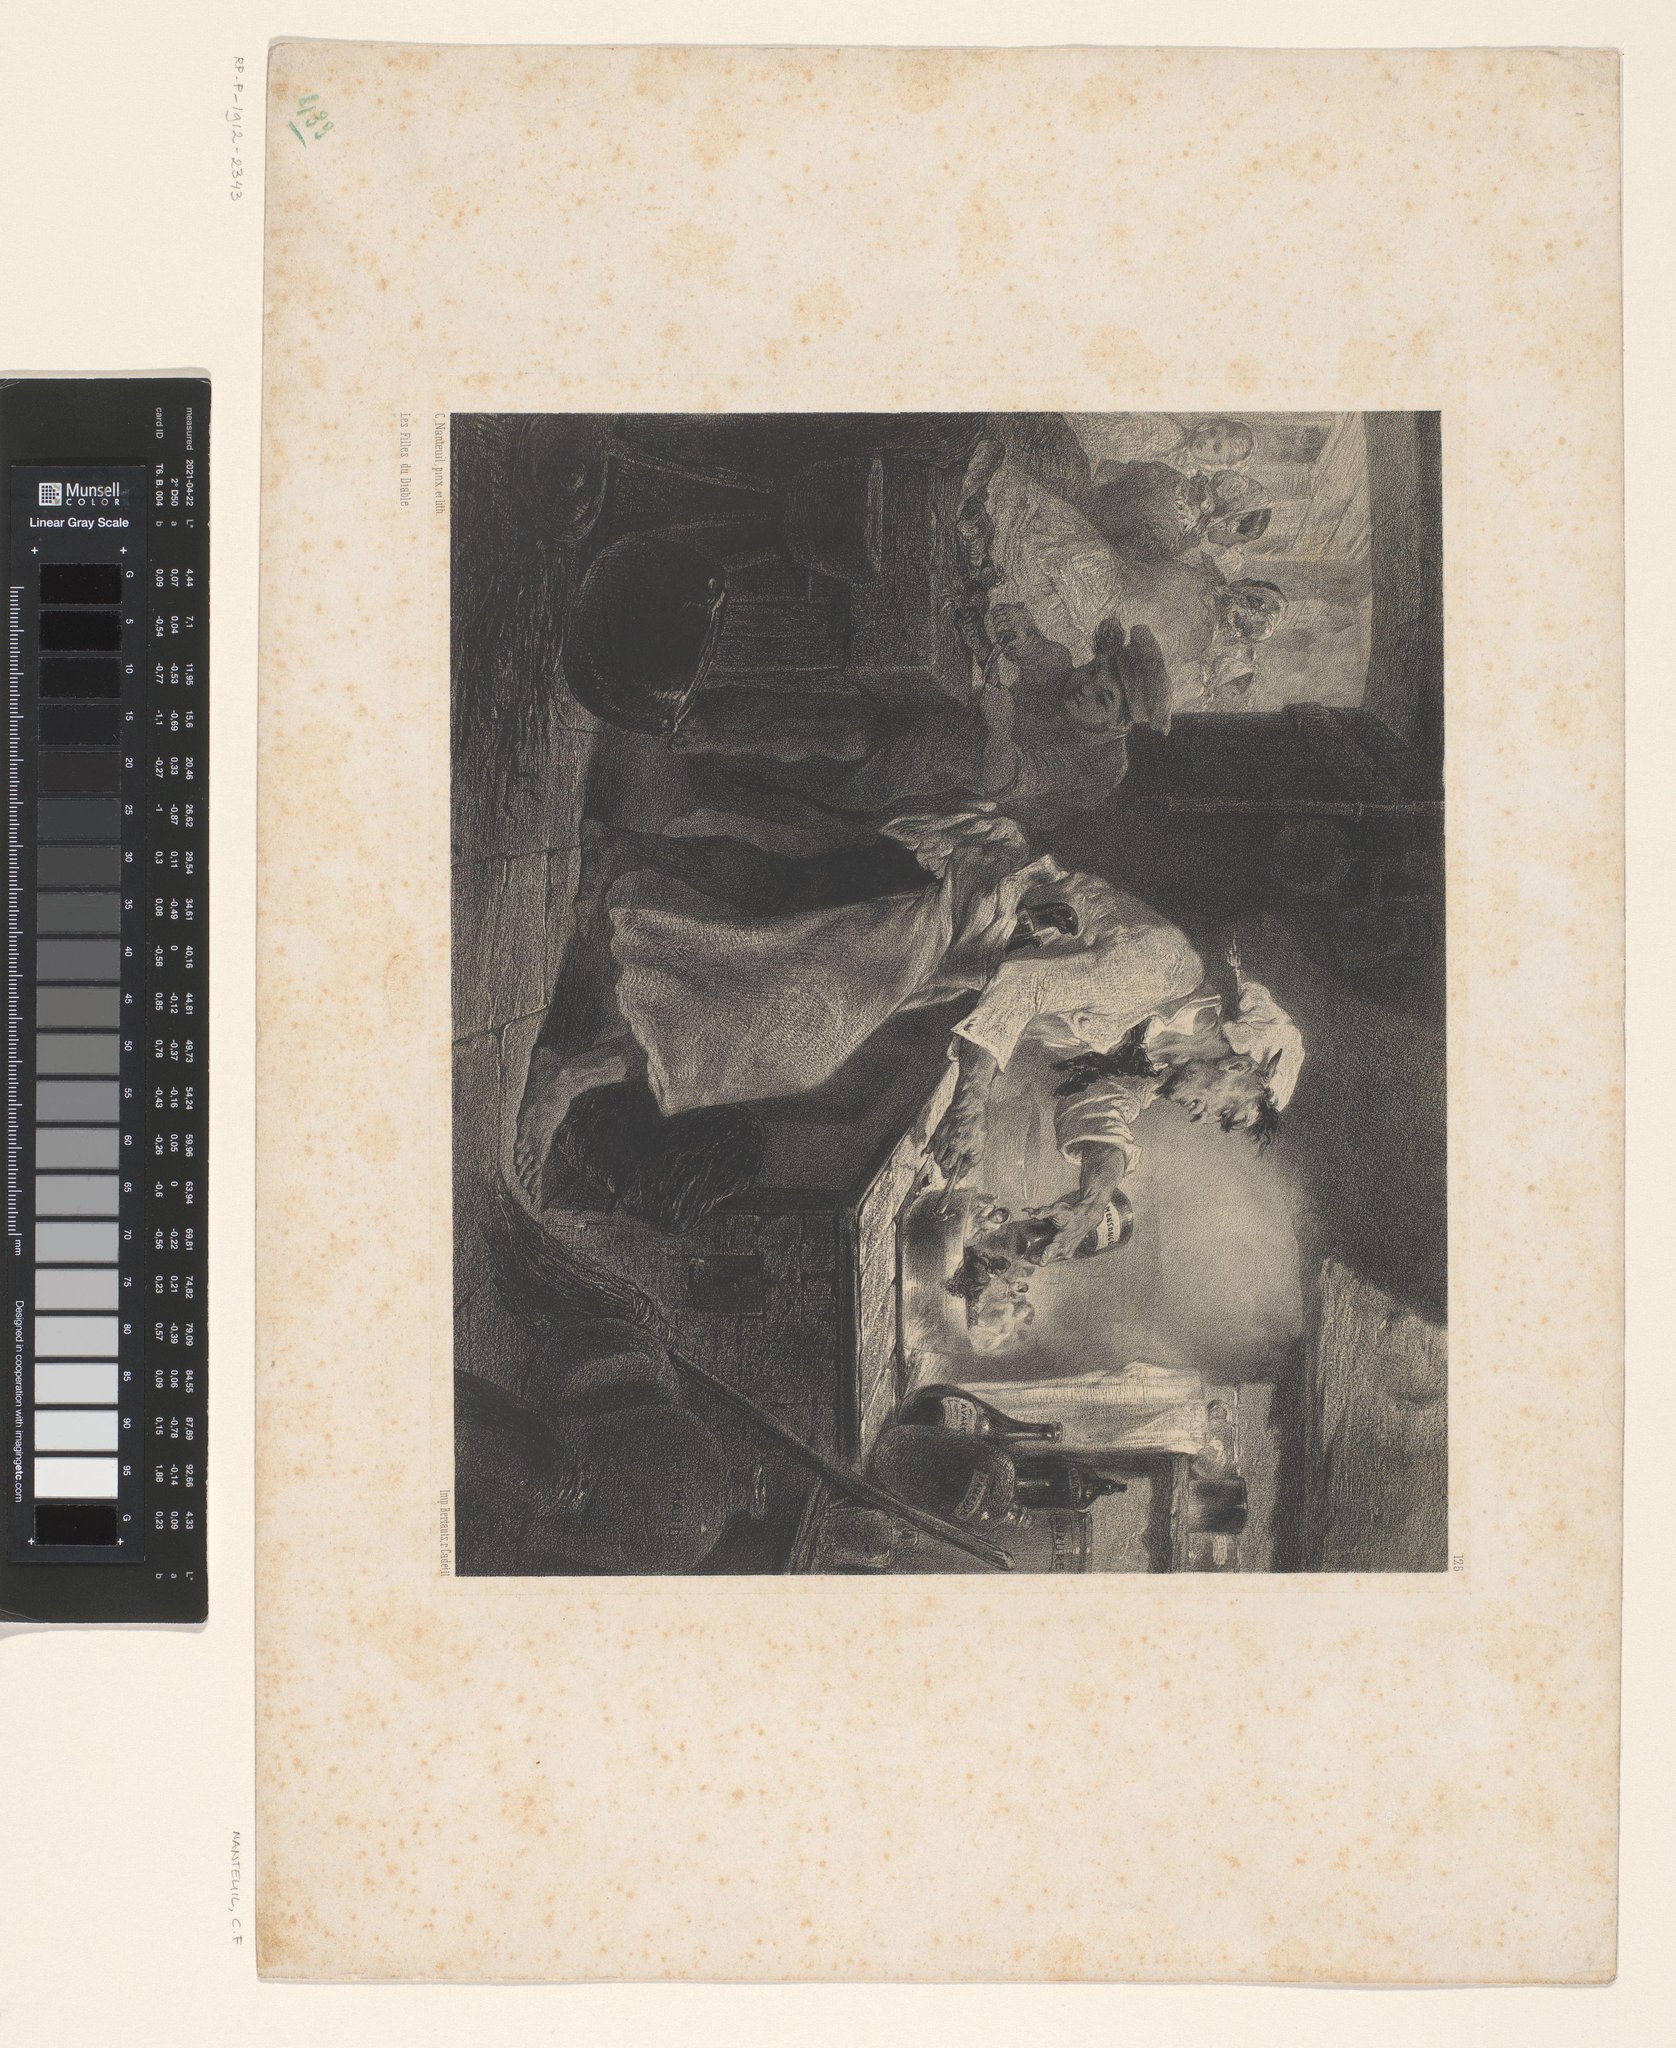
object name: print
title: Oude en hedendaagse kunstenaars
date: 1855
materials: paper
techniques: lithograph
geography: paris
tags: adolescent, young woman, maiden, kitchen, devil(s) and demons, cook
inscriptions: check stamp: Lugt 36a, collector's mark: Lugt 2228